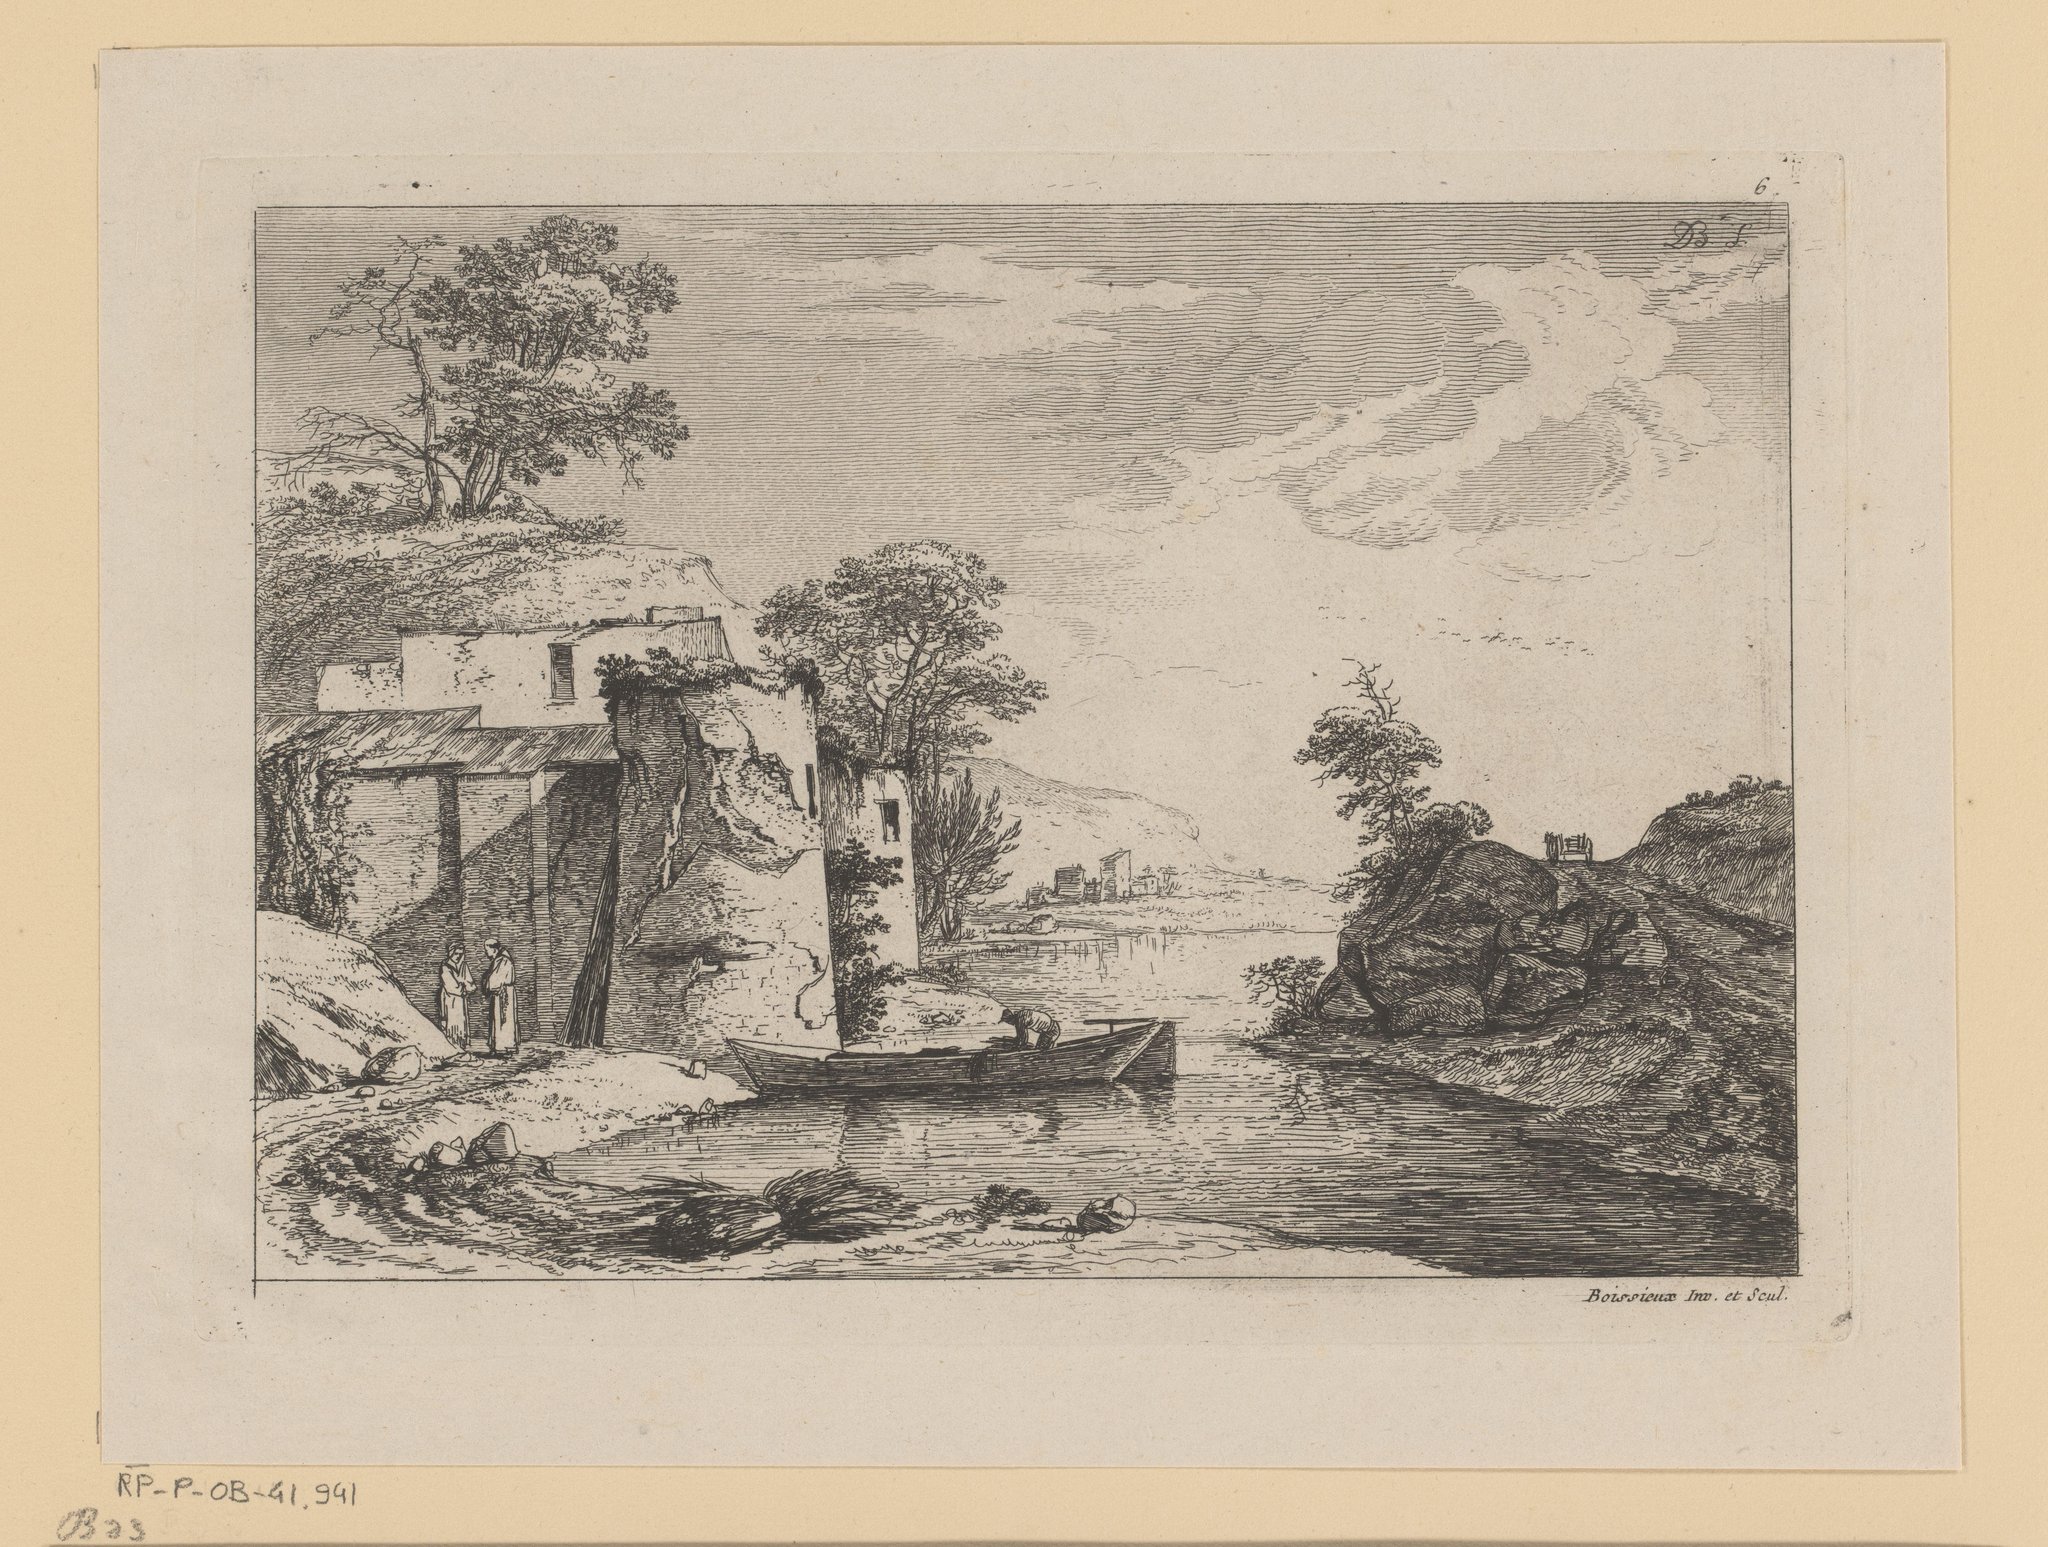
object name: print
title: Suite de dix Paysages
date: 1763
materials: paper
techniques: etching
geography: france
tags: landscapes with waters, waterscapes, seascapes (in the temperate zone), landscapes (+ landscape with figures, staffage), boat propelled by man or animal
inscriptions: collector's mark: Lugt 12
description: Maakt deel uit van een tiendelige serie met landschappen, uitgegeven door Basan te Parijs in 1763.